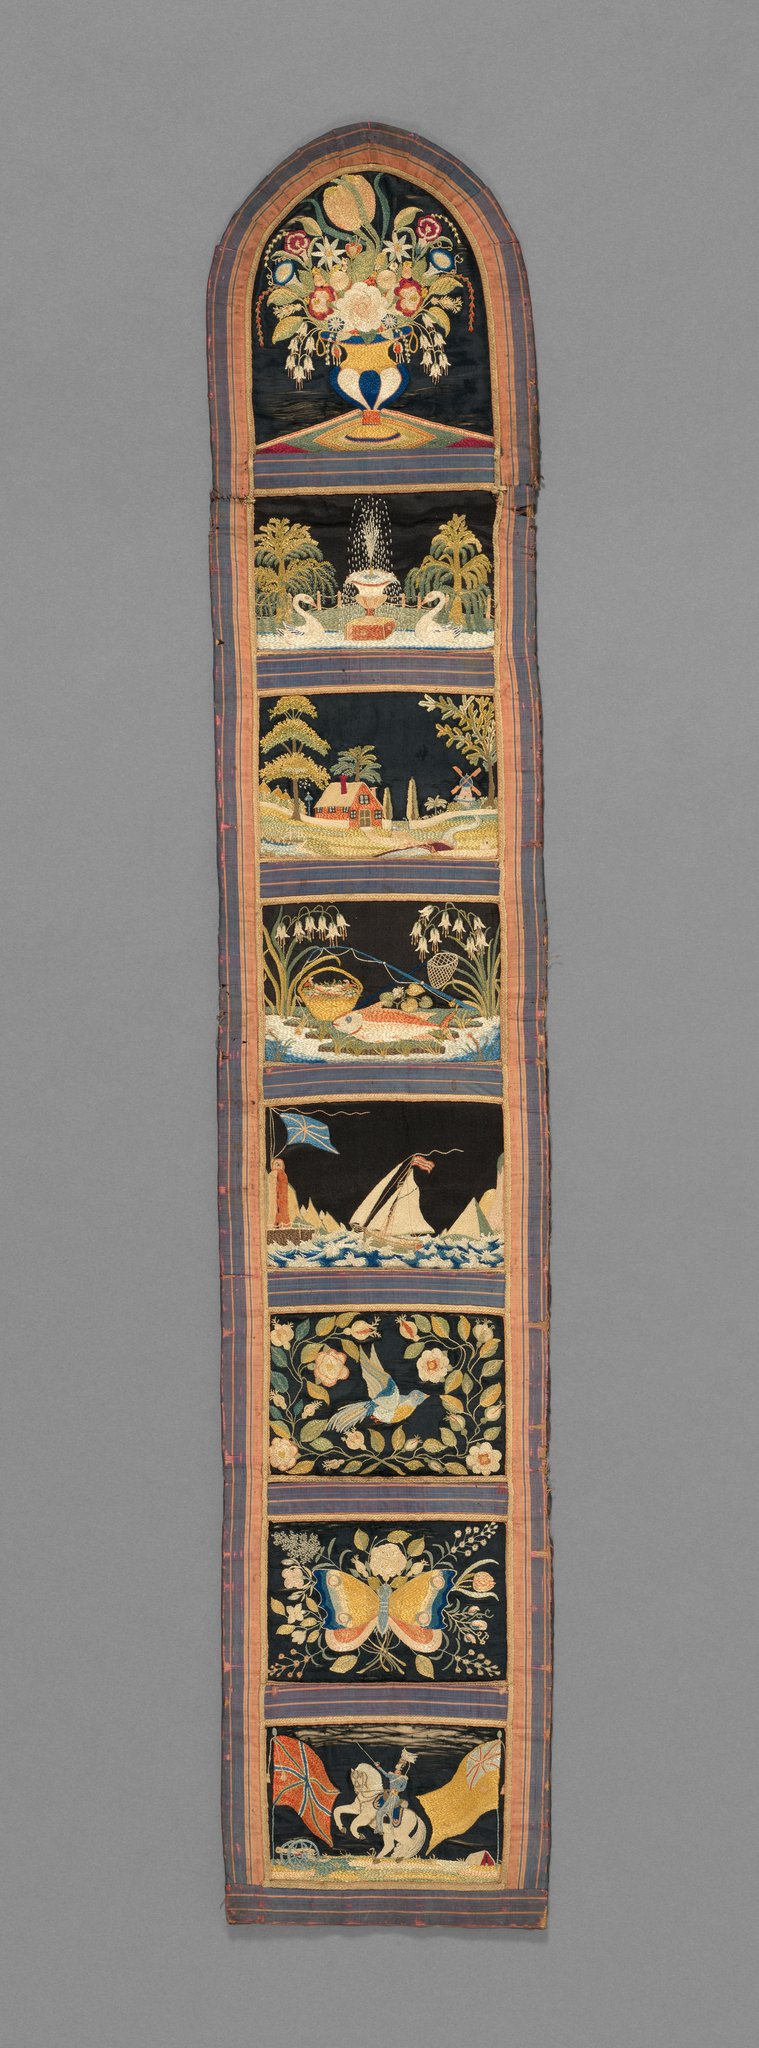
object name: pocket hanger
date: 1800-1825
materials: cotton, linen, silk